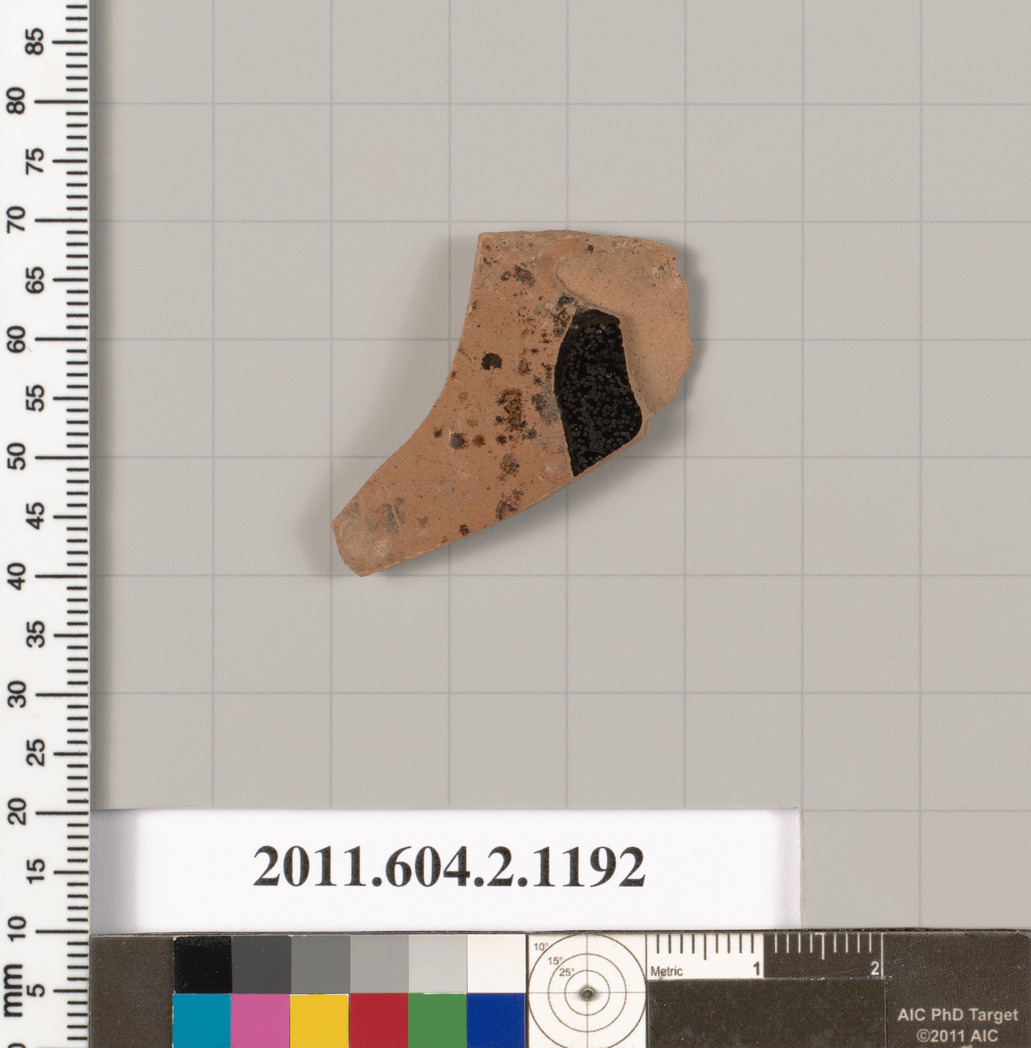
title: Terracotta fragment from a closed shape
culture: greek, attic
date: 450-401 BCE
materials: terracotta